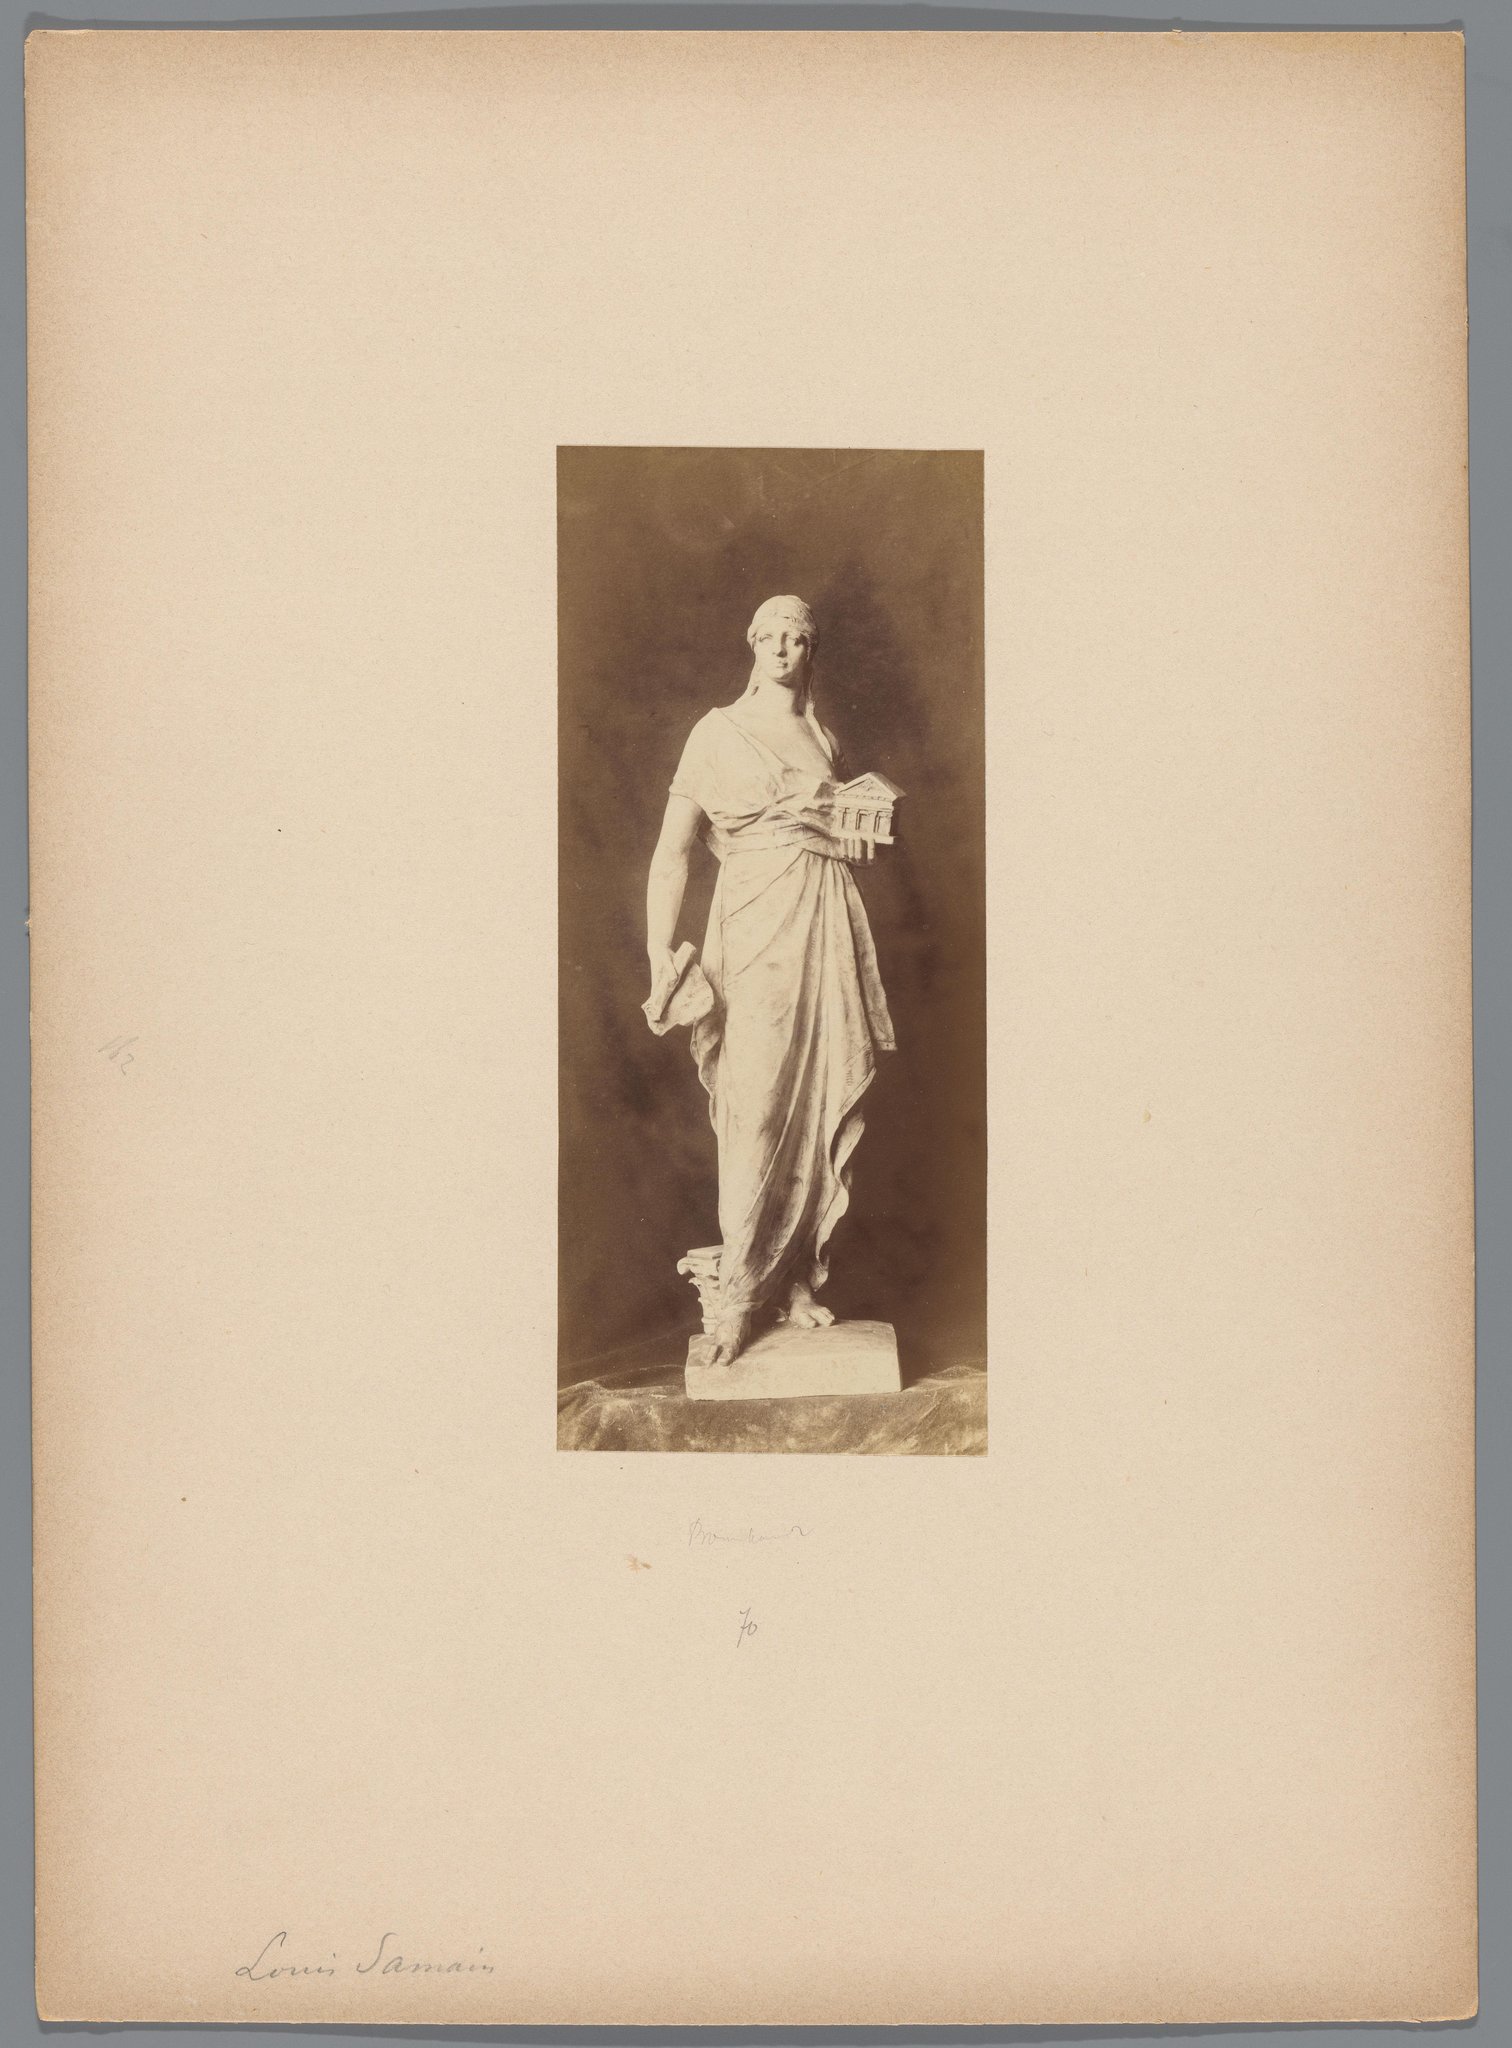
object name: photograph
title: Fotoreproductie van het beeldhouwwerk De Bouwkunst door Louis Samain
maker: Anonymous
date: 1880-1887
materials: cardboard, paper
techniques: albumen print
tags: piece of sculpture, reproduction of a piece of sculpture, 'architectura', symbolic representations, allegories and emblems ~ architecture; 'architettura' (ripa)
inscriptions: inscription: ‘Louis Samain’, collector's mark: Lugt 2228, inscription: ‘Bouwkunst/ 70/ 162’